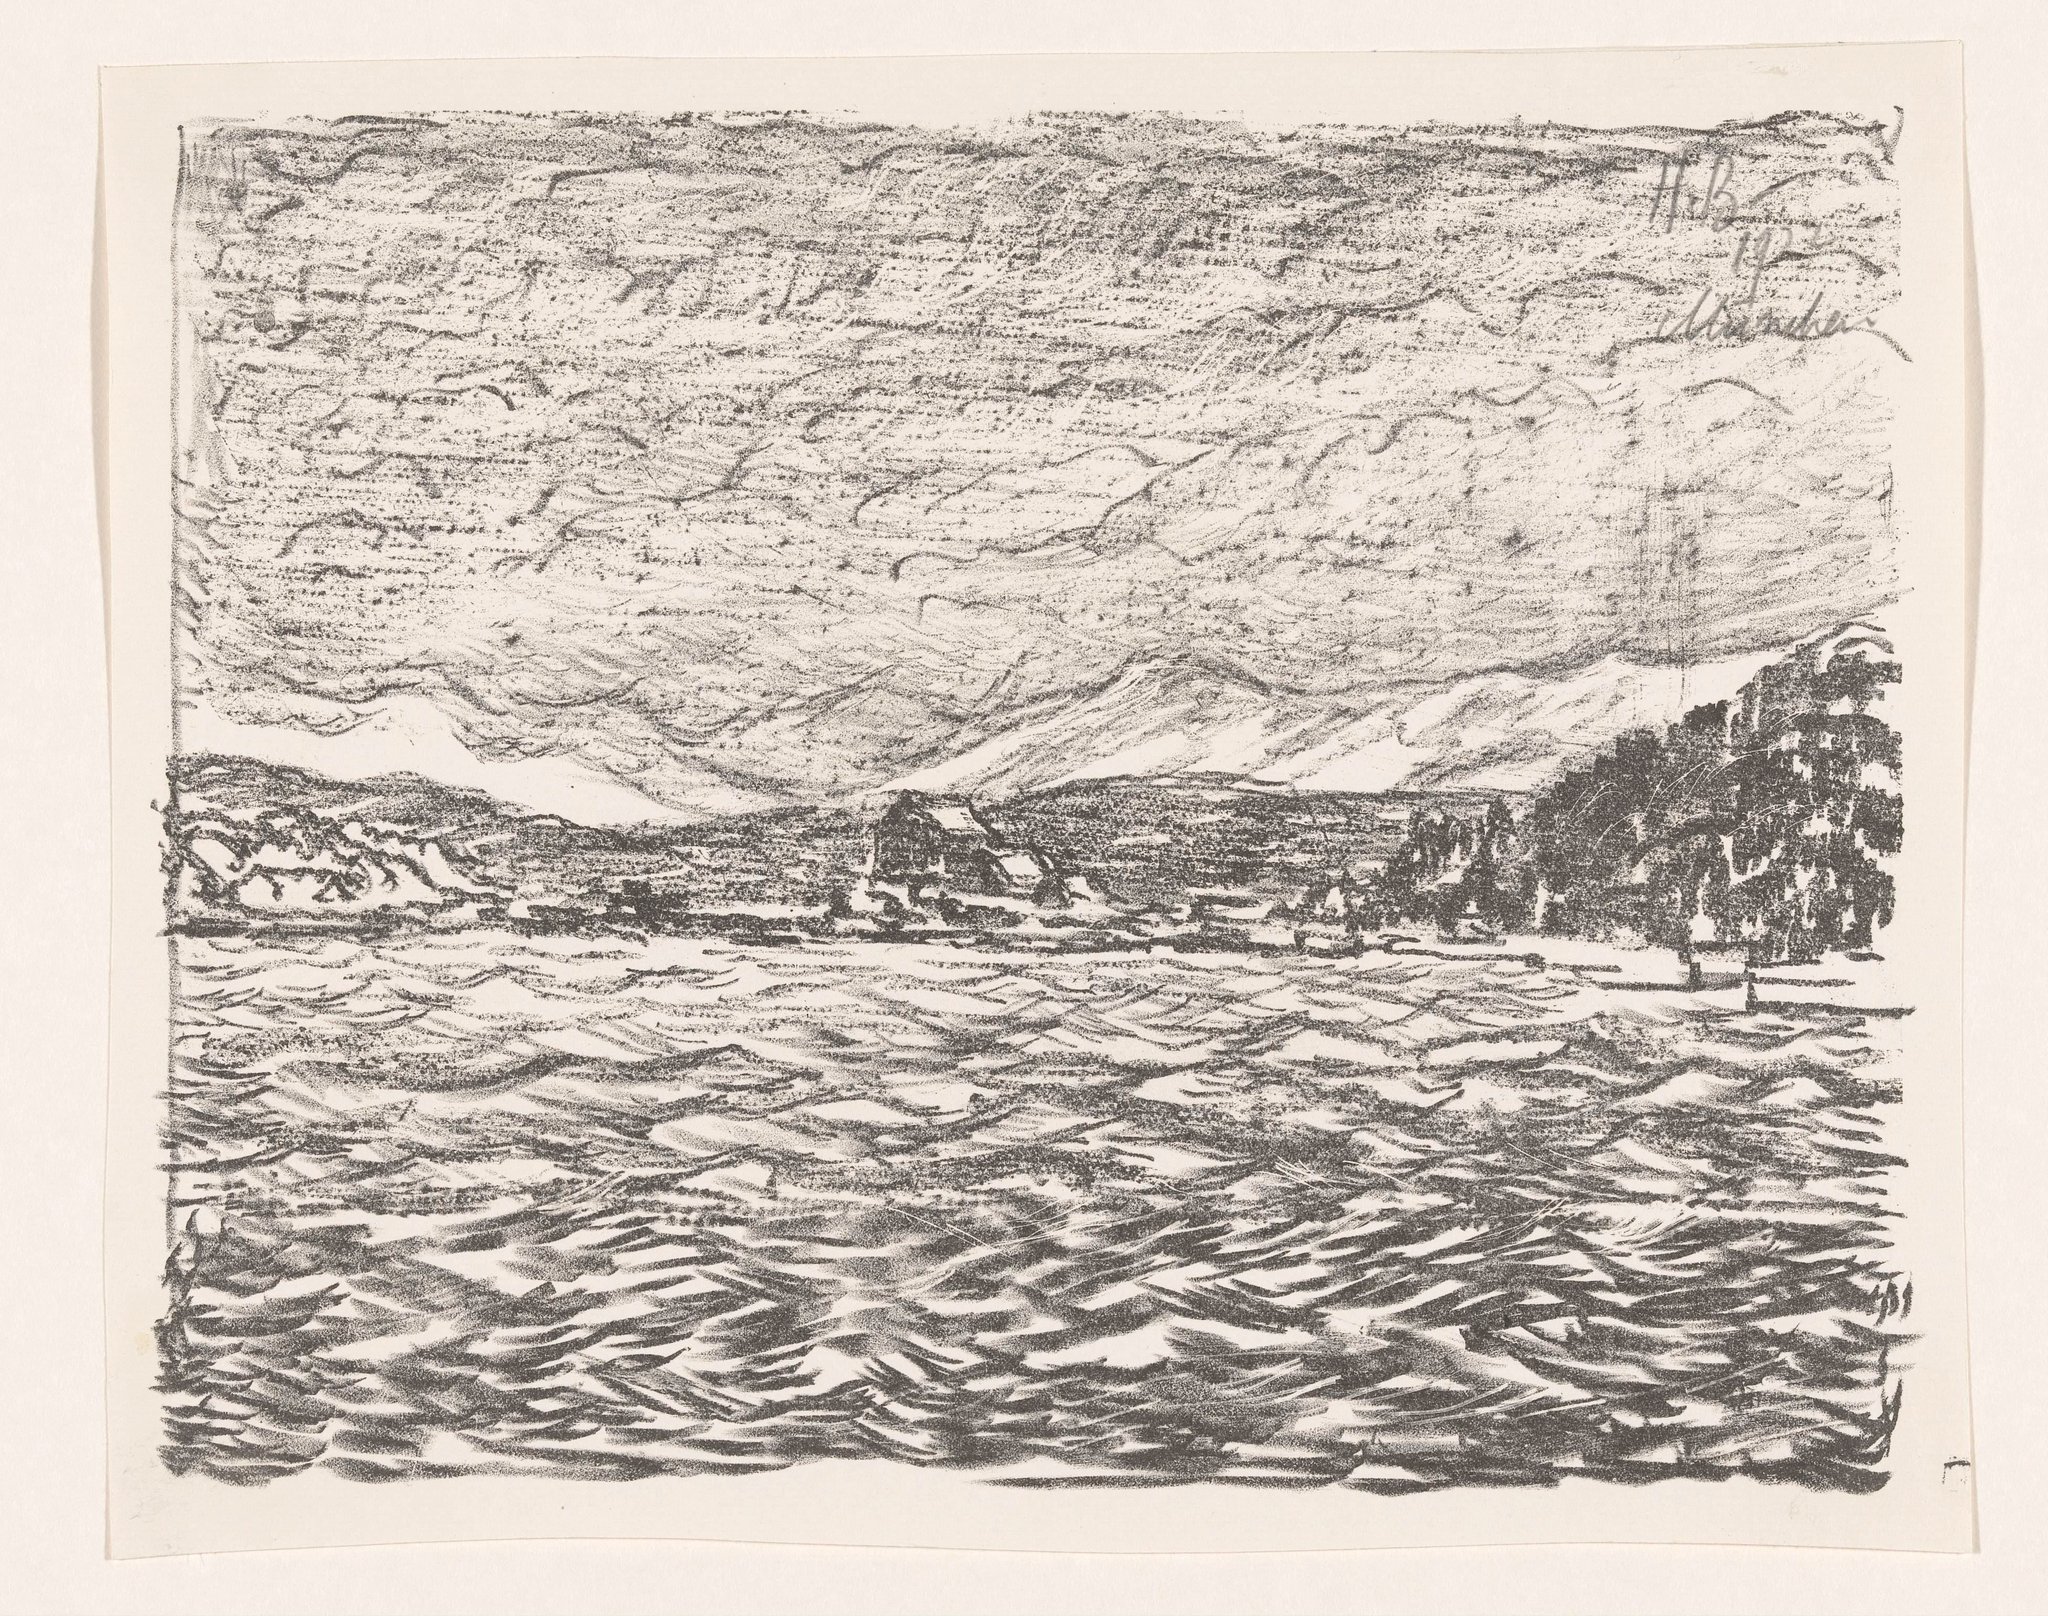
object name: print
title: Starnberger See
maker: henri braakensiek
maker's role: print maker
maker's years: 1891-1941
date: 1922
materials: paper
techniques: lithograph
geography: munich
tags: low hill country, lake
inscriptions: collector's mark: Lugt 2228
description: Heuvels en een nederzetting aan aan de Starnberger See in Beieren.